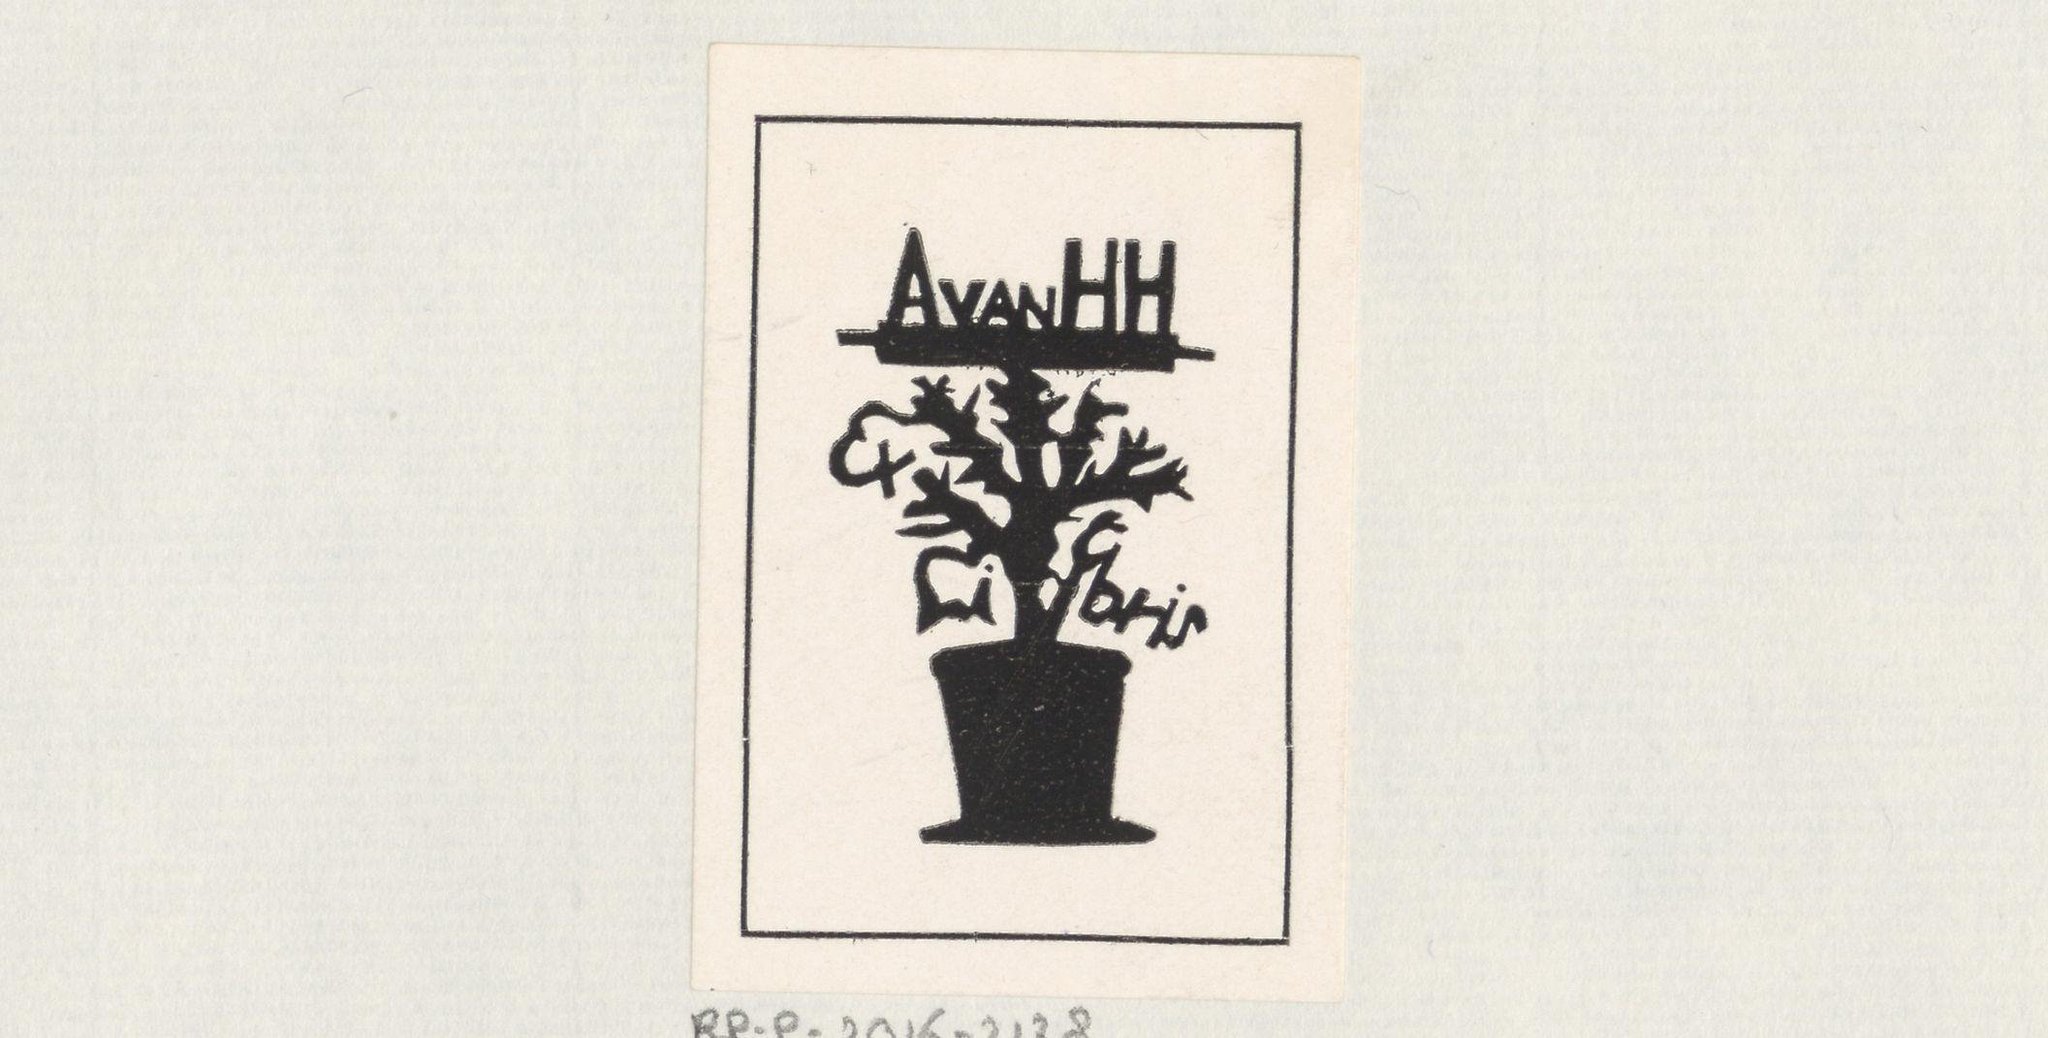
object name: bookplate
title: Ex libris van A. van H.H.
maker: Anonymous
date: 1953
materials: paper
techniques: printing block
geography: netherlands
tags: potted plants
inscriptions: inscription: ‘Knipprend (?) / if / 53’